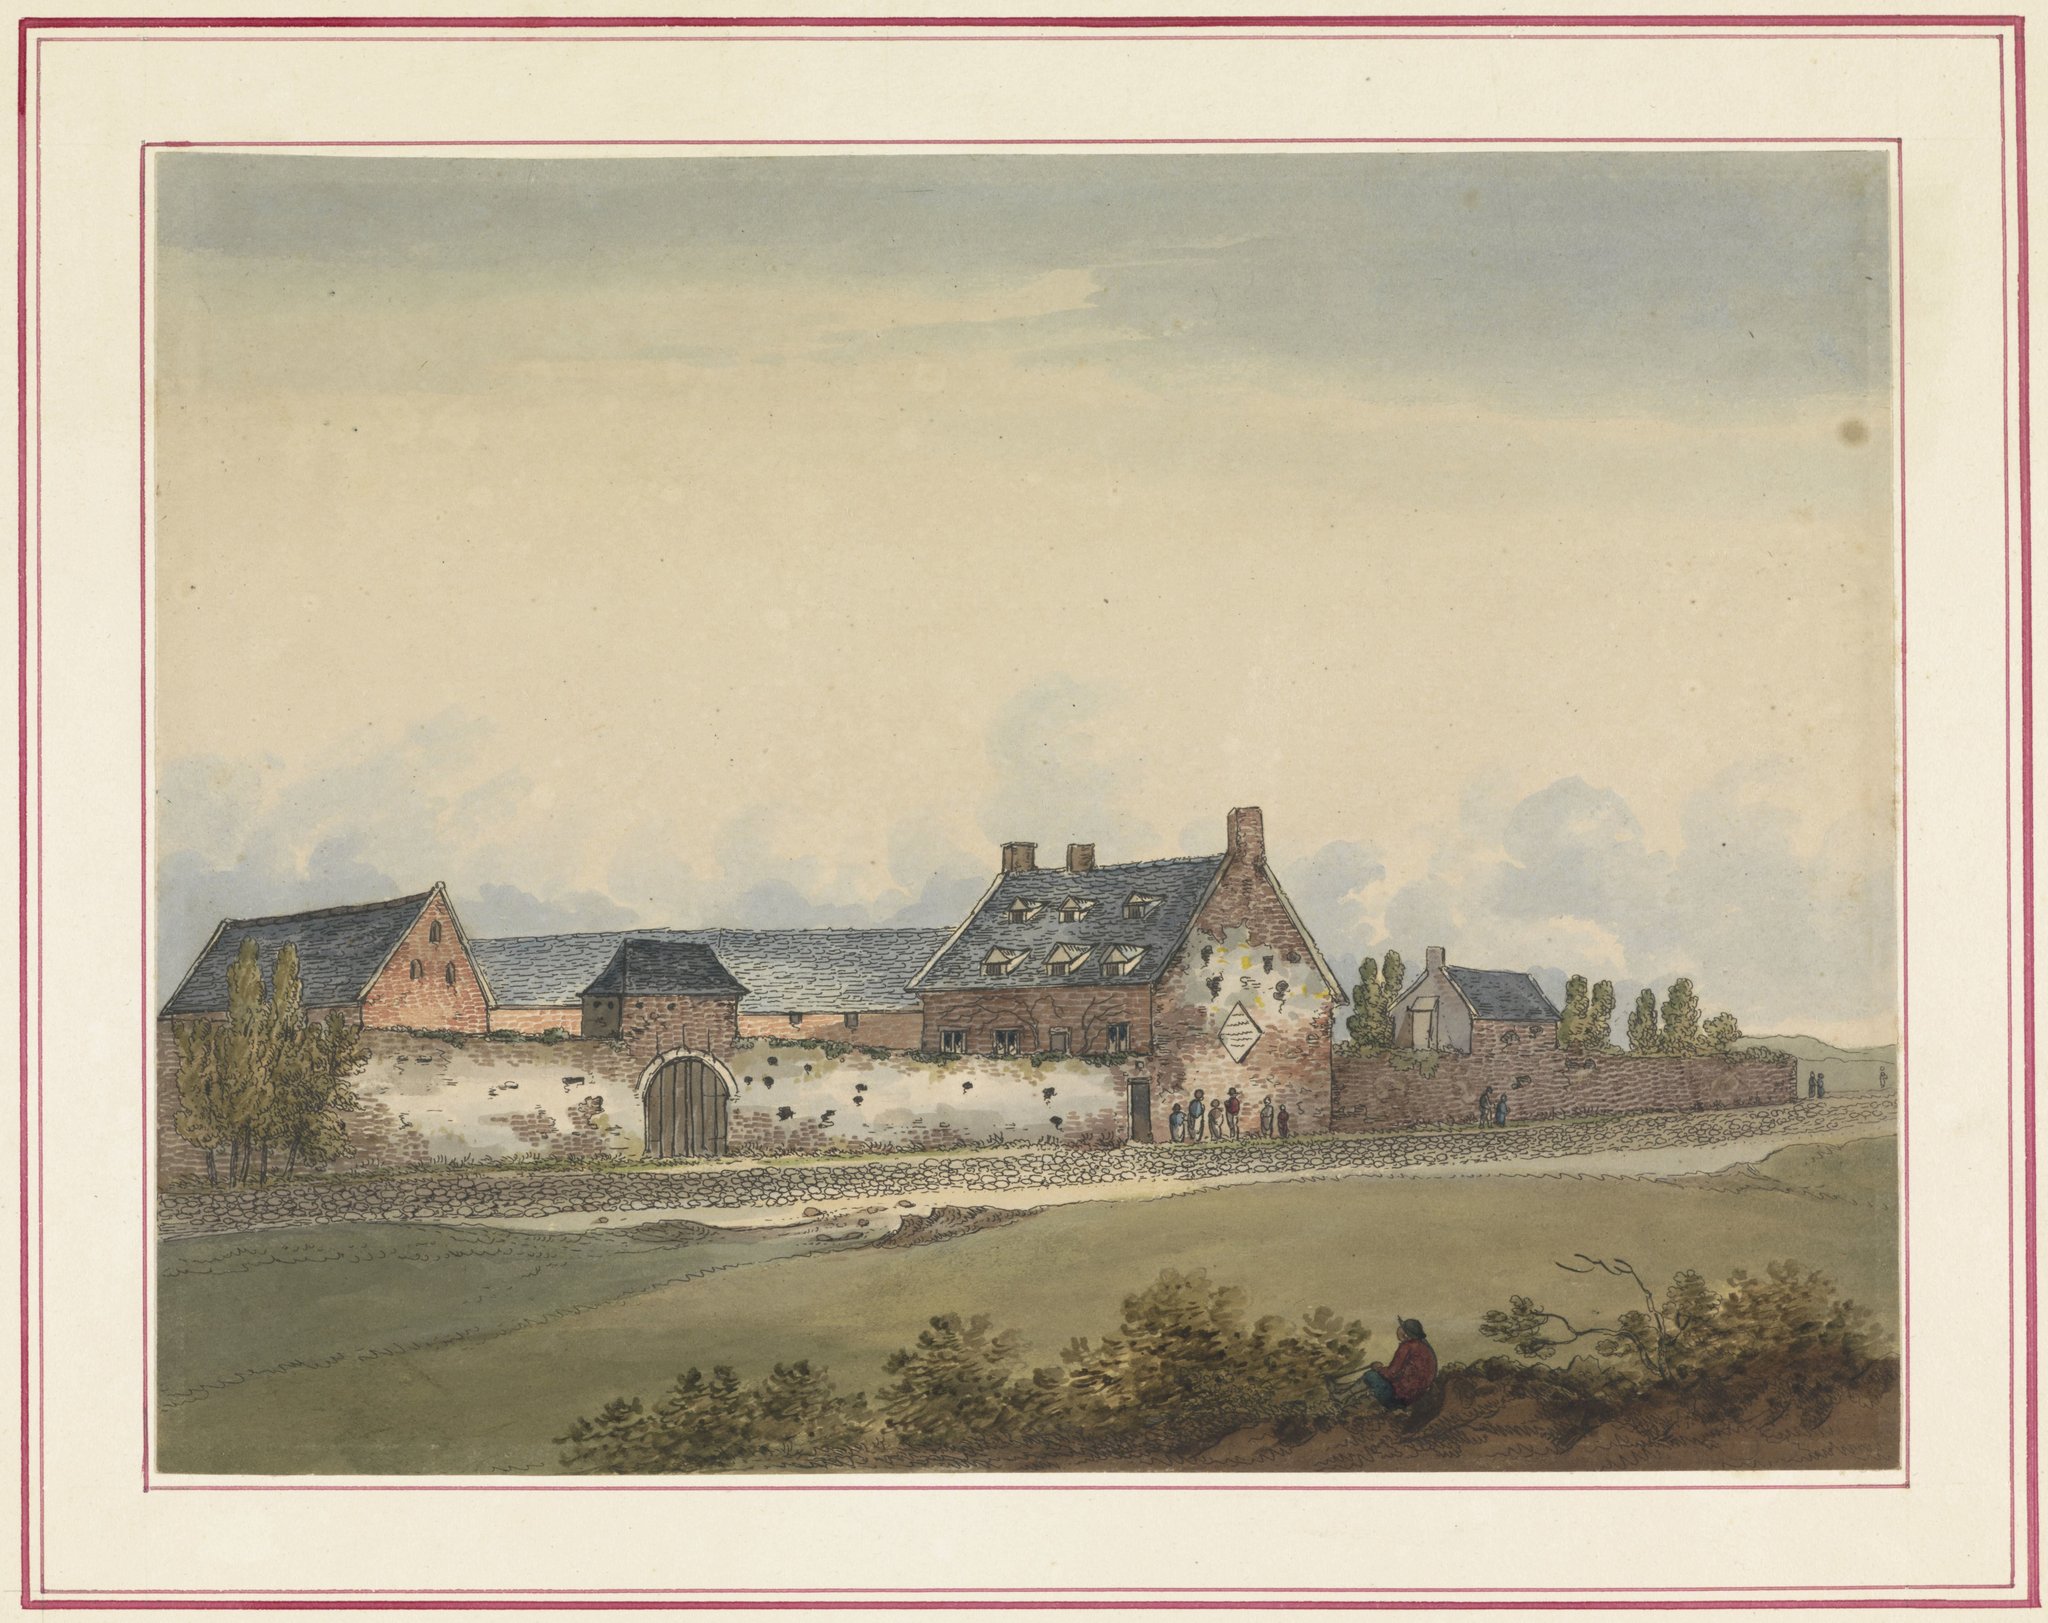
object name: print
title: Hoeve La Haye-Sainte in Mont-Saint-Jean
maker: Anonymous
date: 1815-1825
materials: paper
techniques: etching, hand coloring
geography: low countries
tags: farm (building), waterloo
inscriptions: collector's mark: Lugt 2228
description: De hoeve La Haye-Sainte in Mont-Saint-Jean, een dorp nabij Waterloo. Onderdeel van een serie van zeven platen met gezichten uit ca. 1820 van de omgeving waar de slag bij Waterloo plaatsvond op 18 juni 1815.